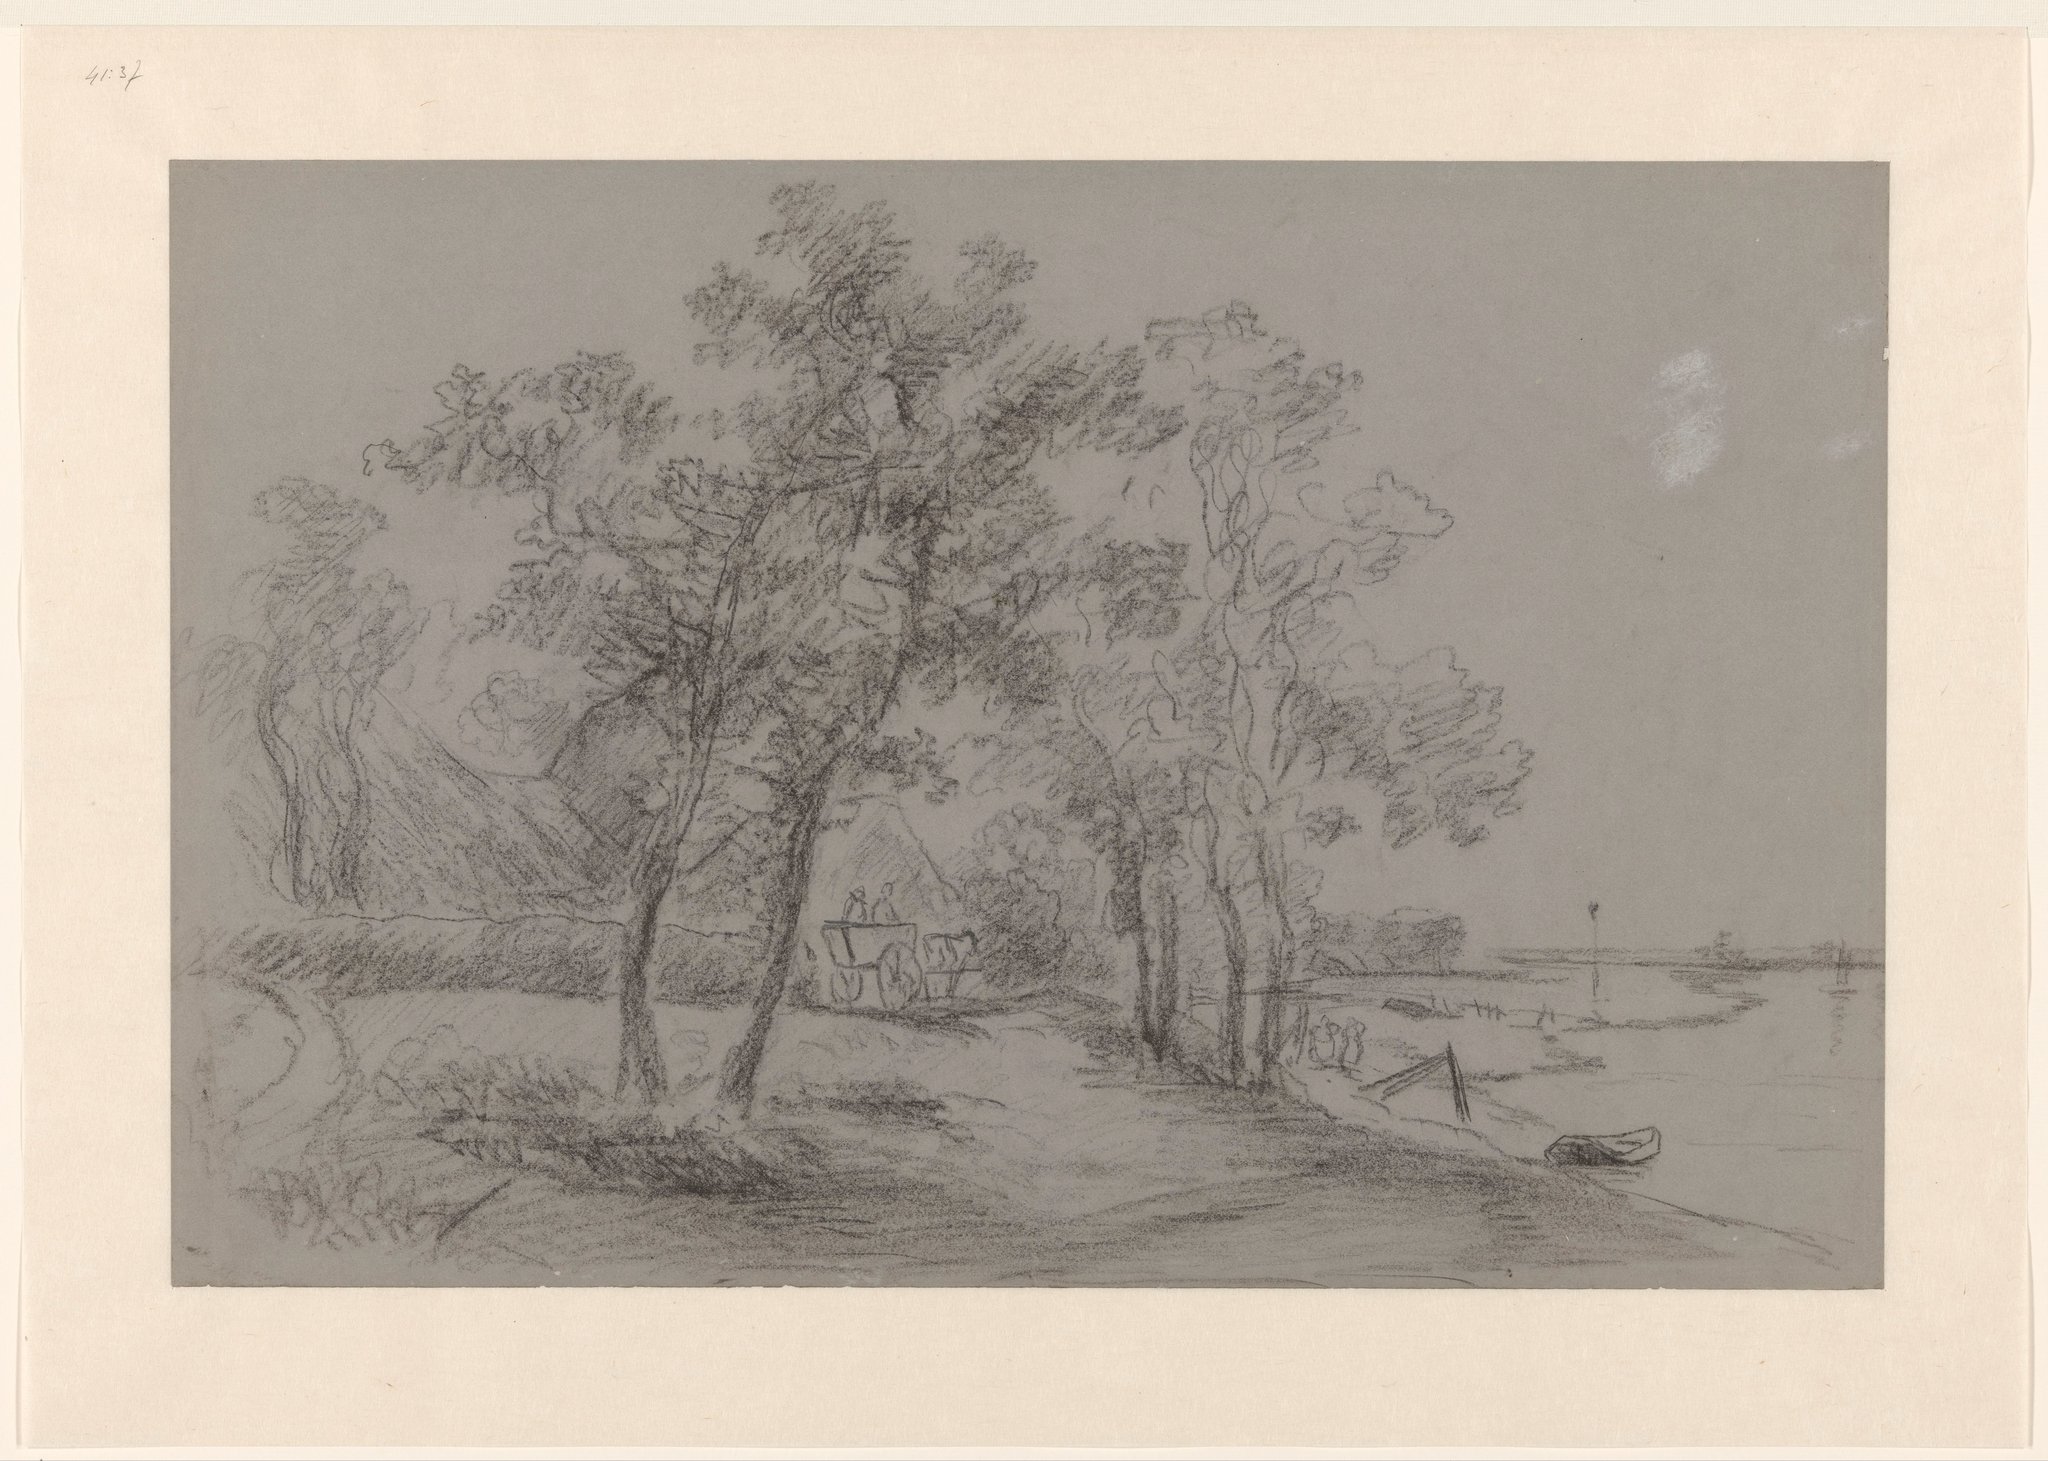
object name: drawing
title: Rivierlandschap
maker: piet meiners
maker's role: draughtsman, painter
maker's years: 1857-1903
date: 1867-1903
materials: chalk, paper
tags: river